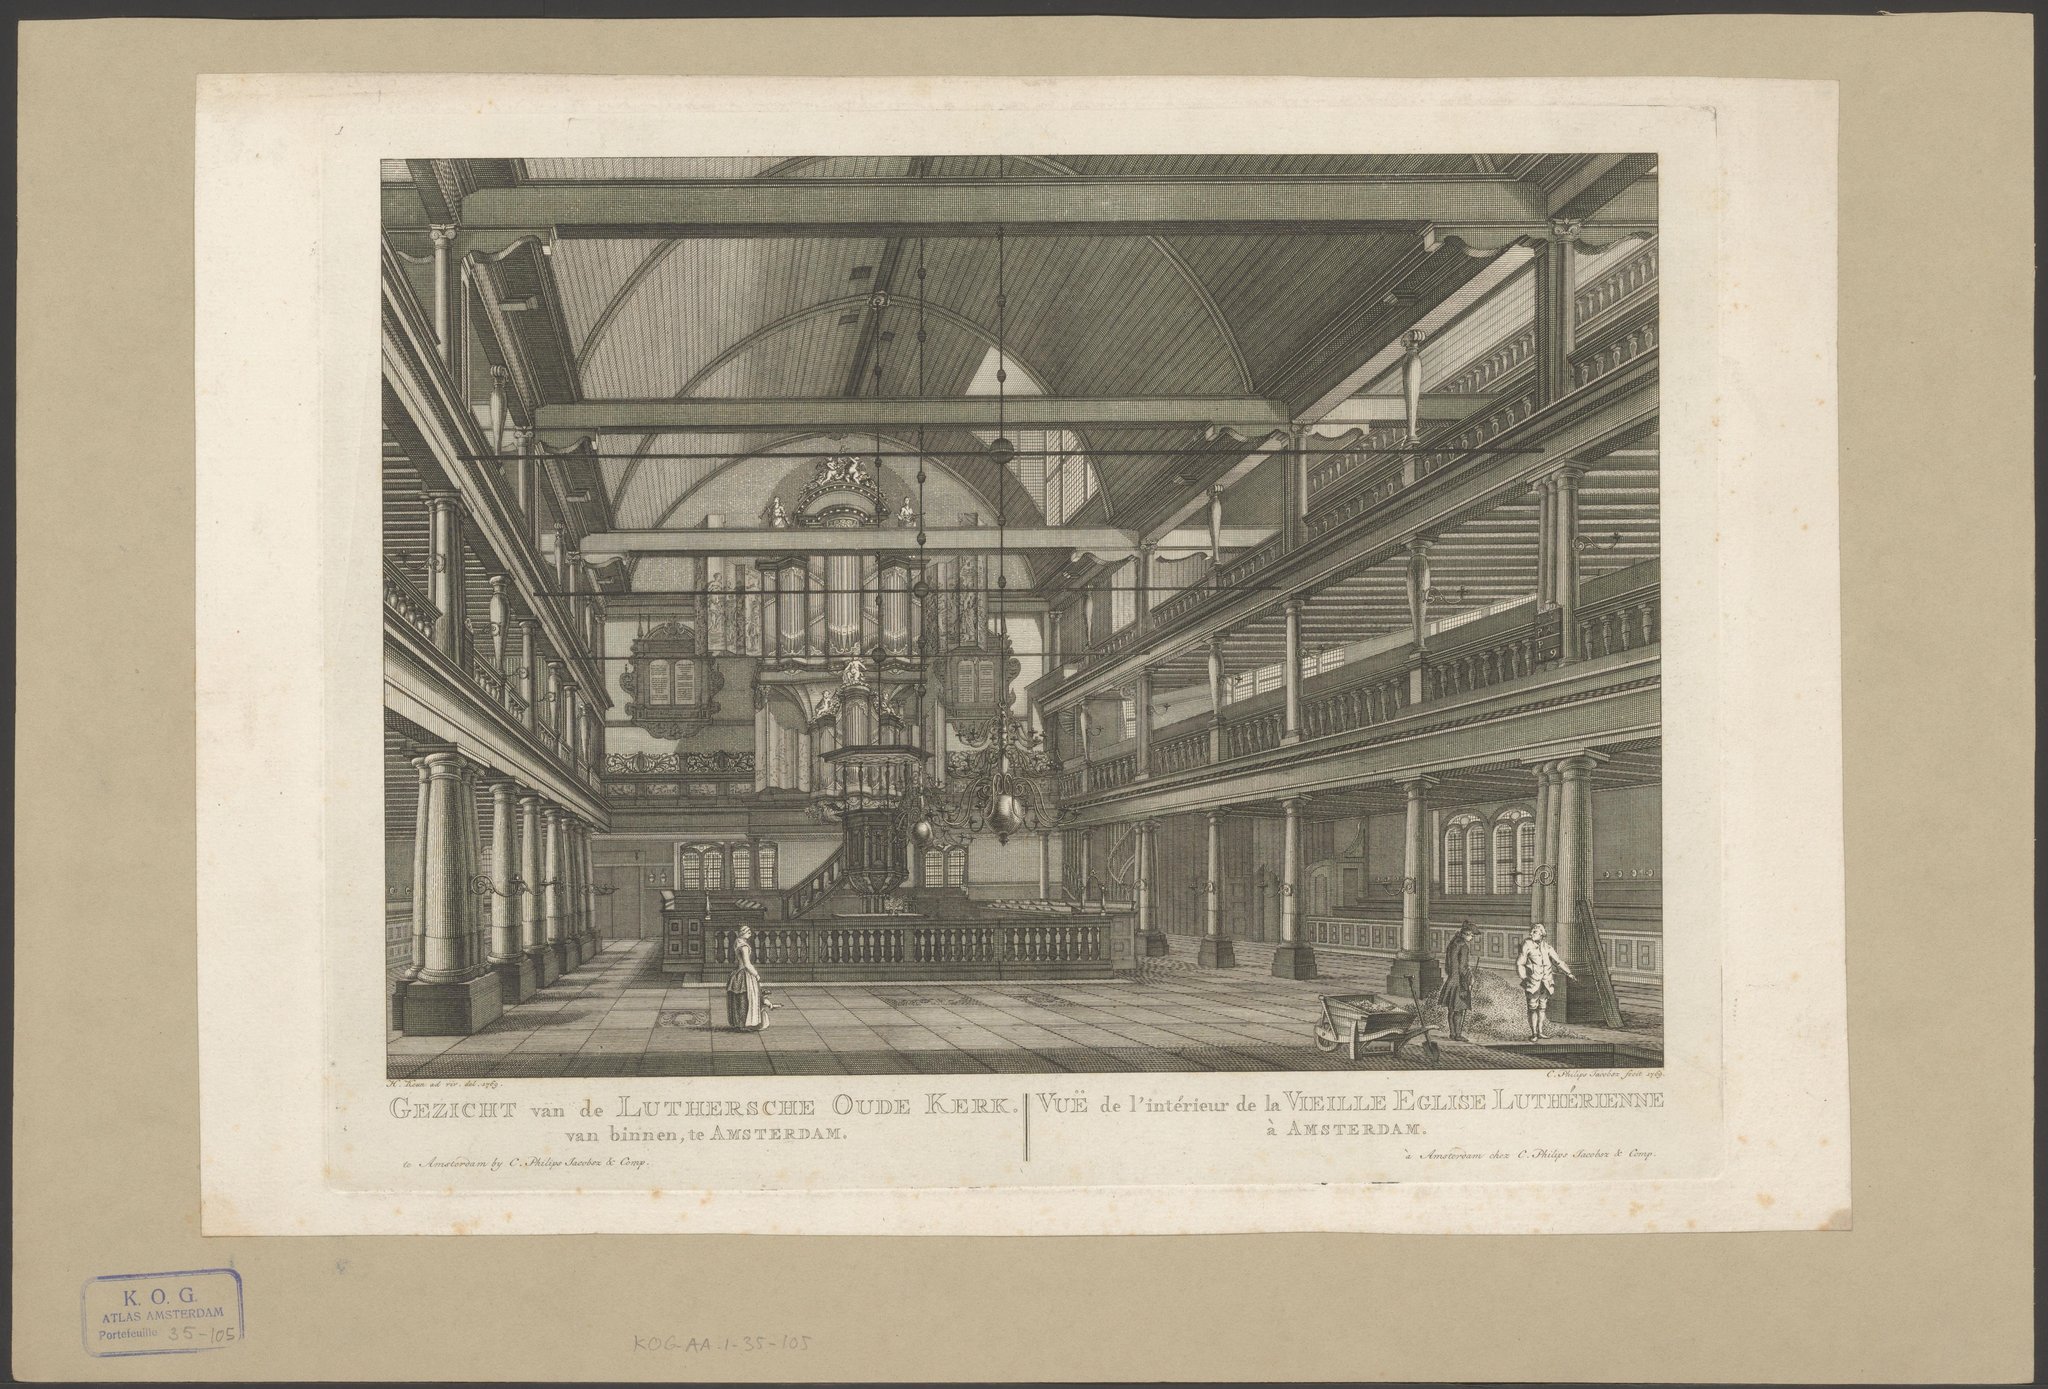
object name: print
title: Interieur van de Lutherse Oude Kerk te Amsterdam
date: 1769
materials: paper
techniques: engraving, etching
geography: amsterdam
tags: protestant churches and denominations (lutherans), interior of church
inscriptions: collector's mark: ‘35-105’ Lugt 1641b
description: Rechtsboven genummerd: 1. Onderwerpsrubriek binnen de Atlas Amsterdam: Ev. Lutherse Gemeente: Oude Kerk (Spui).